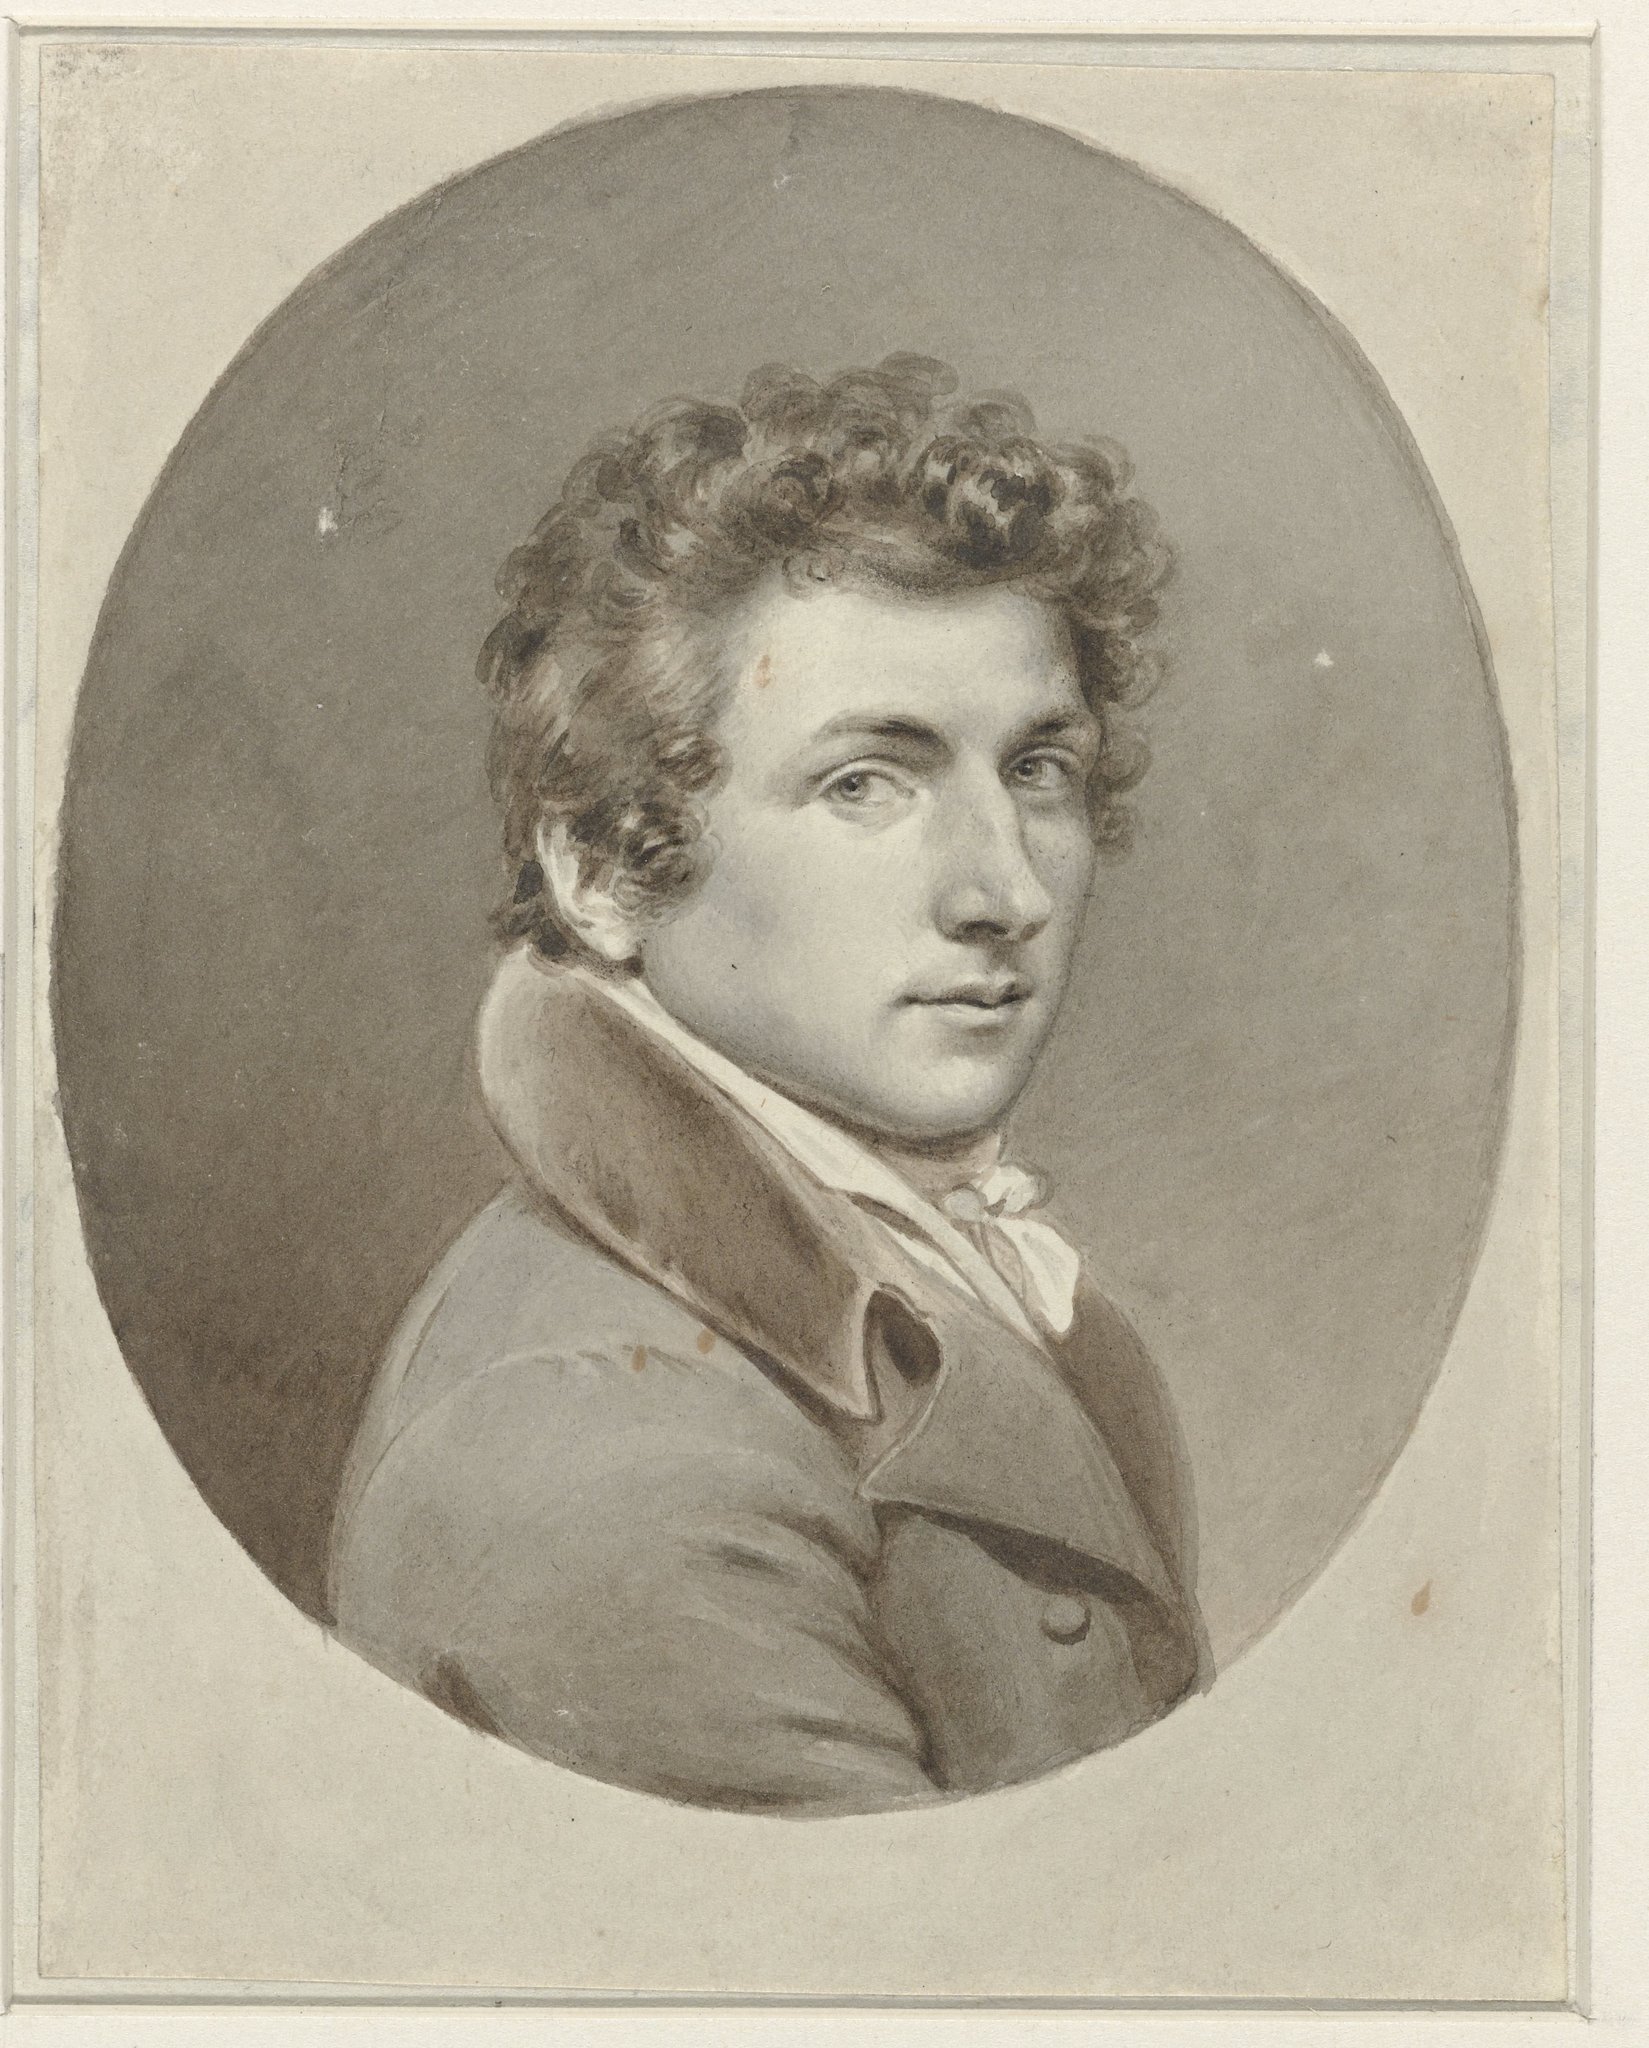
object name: drawing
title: Zelfportret van Woutherus Mol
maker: woutherus mol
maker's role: draughtsman, painter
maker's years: 1785-1857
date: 1810-1820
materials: paper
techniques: brush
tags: painter, woutherus mol, historical persons, portrait, self-portrait of artist